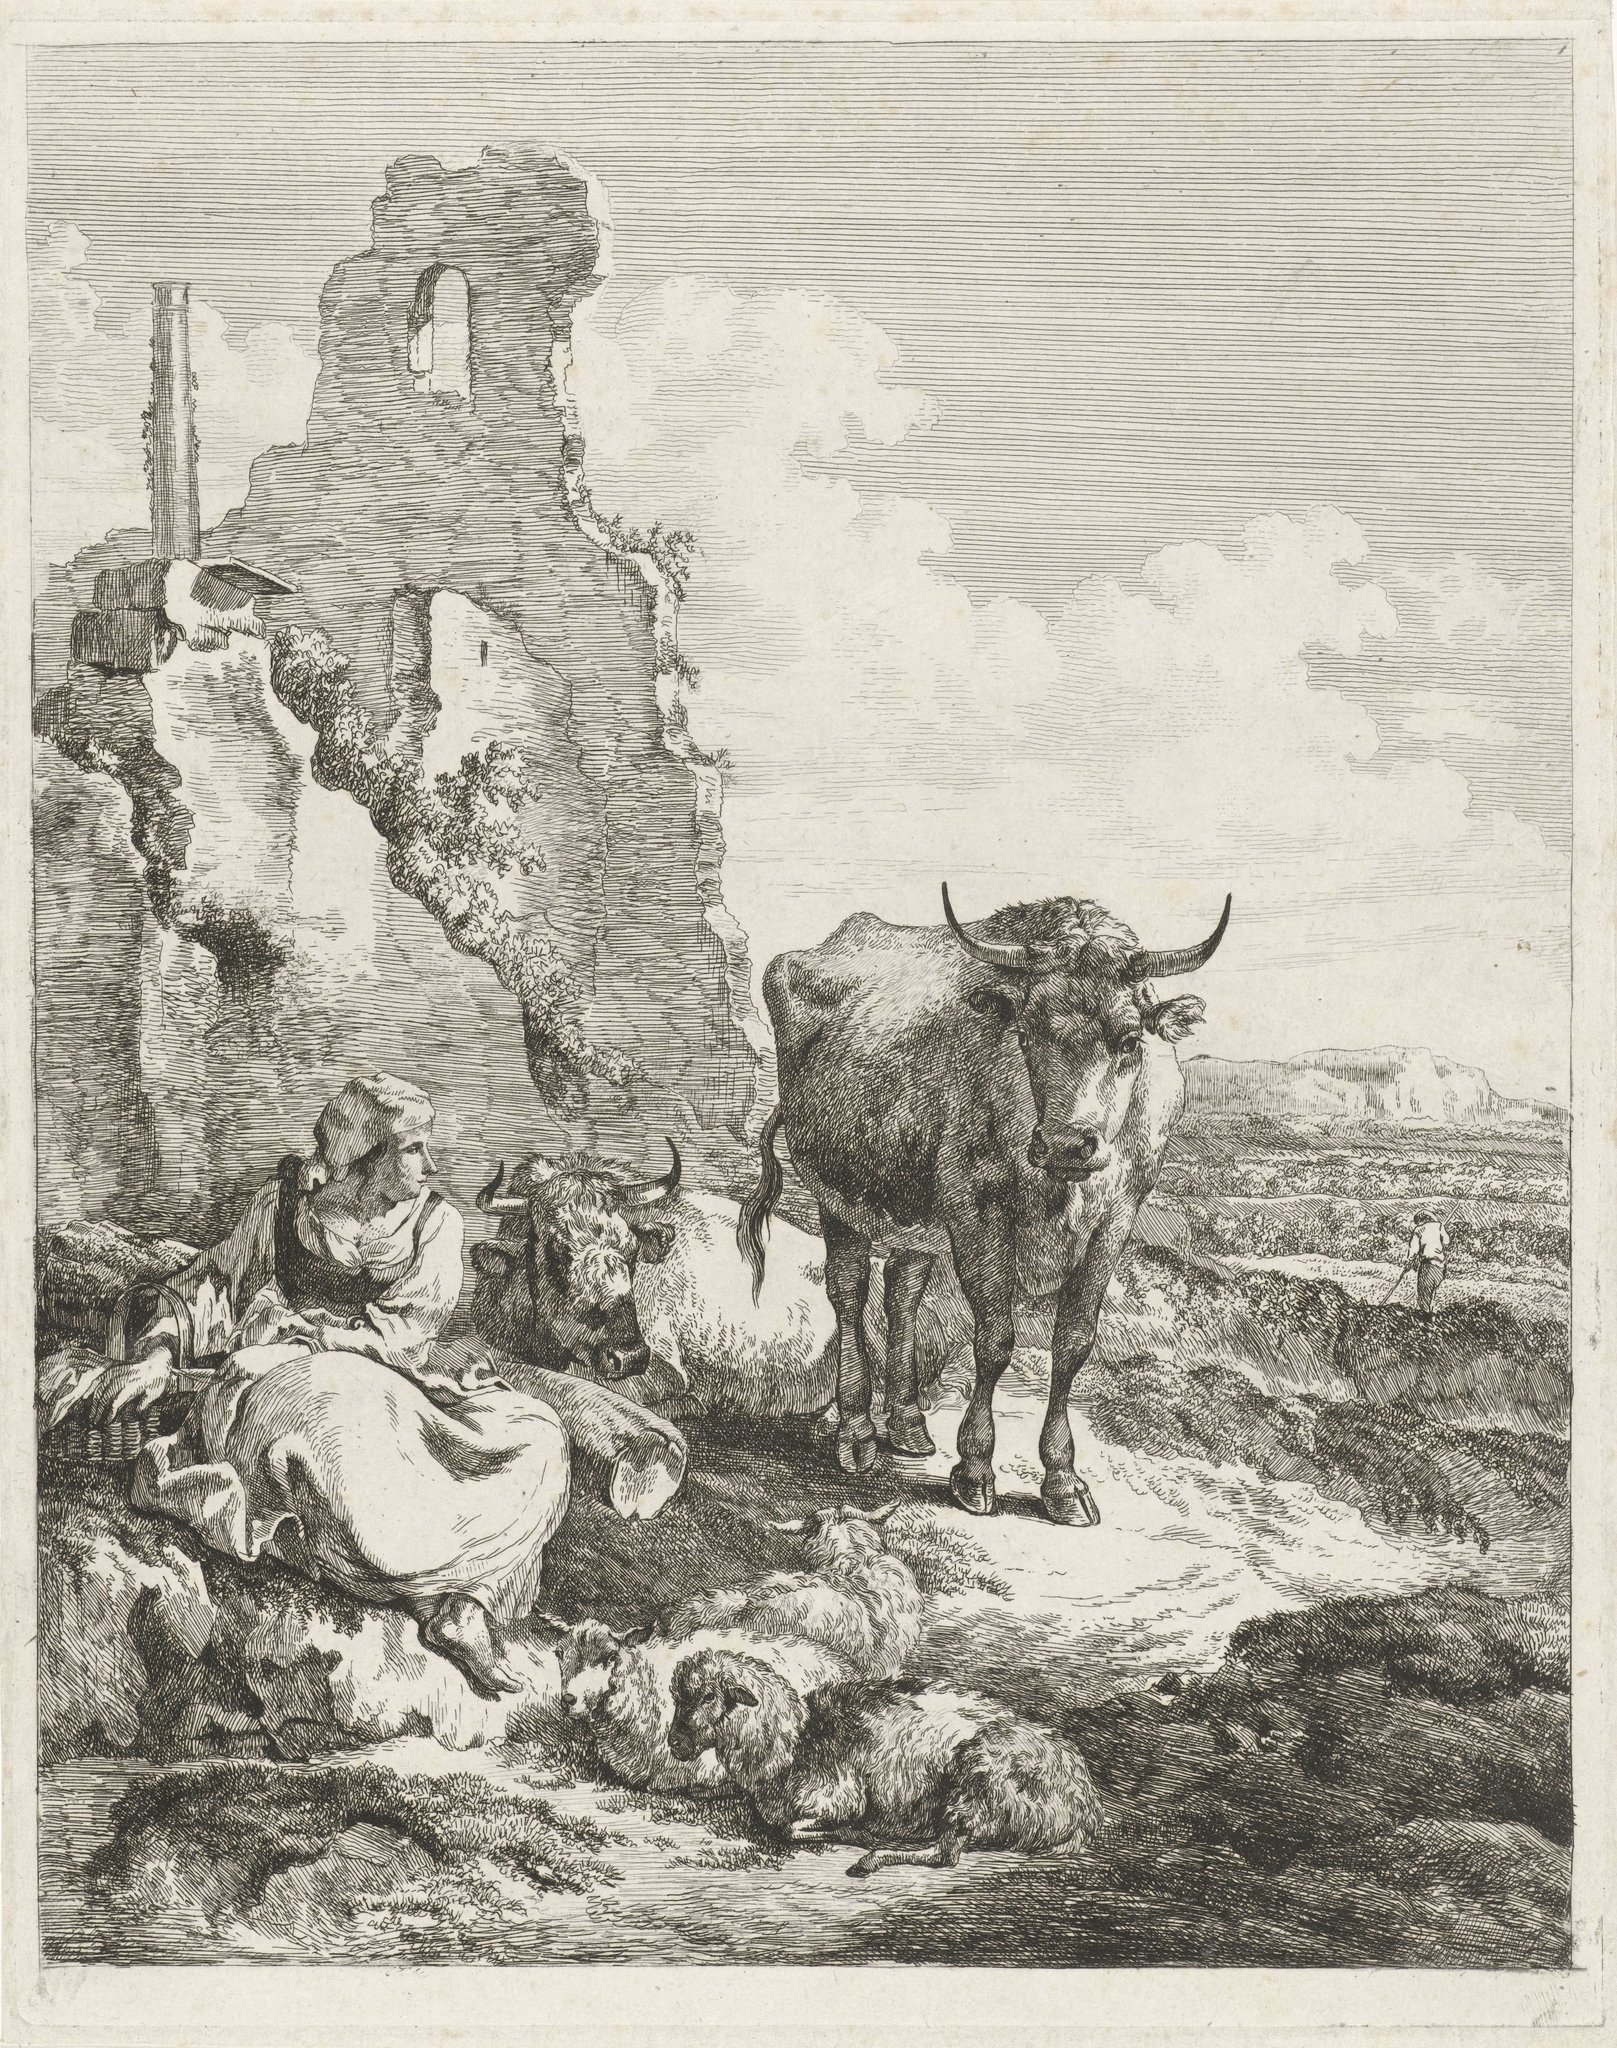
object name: print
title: Landschap met staande en liggende koe en herderin voor een ruïne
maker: pieter gerardus van os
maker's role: draughtsman, painter, print maker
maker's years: 1776-1839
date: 1791-1839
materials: paper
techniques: etching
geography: the hague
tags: cow, herding, herdsman, herdswoman, shepherd, shepherdess, cowherd, etc.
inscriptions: collector's mark: Lugt 2228